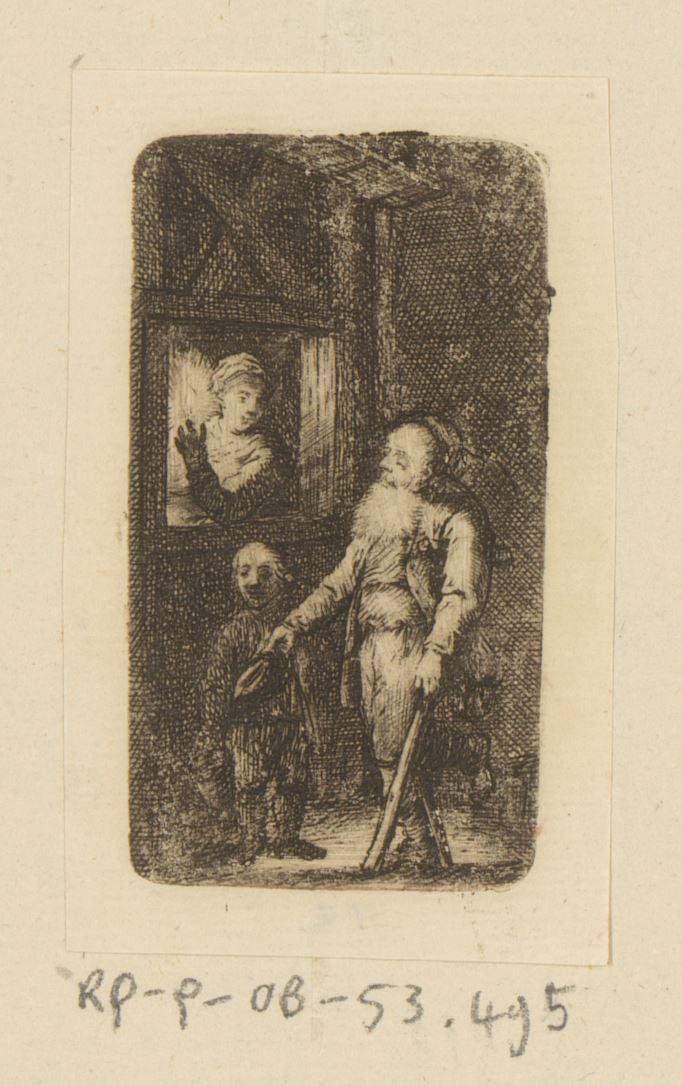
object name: print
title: Oude bedelende man met jongen bij een vrouw met kaars in een venster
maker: johann andreas benjamin nothnagel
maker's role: print maker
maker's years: 1729-1804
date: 1739-1804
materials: paper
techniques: etching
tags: beggar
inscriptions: collector's mark: Lugt 240